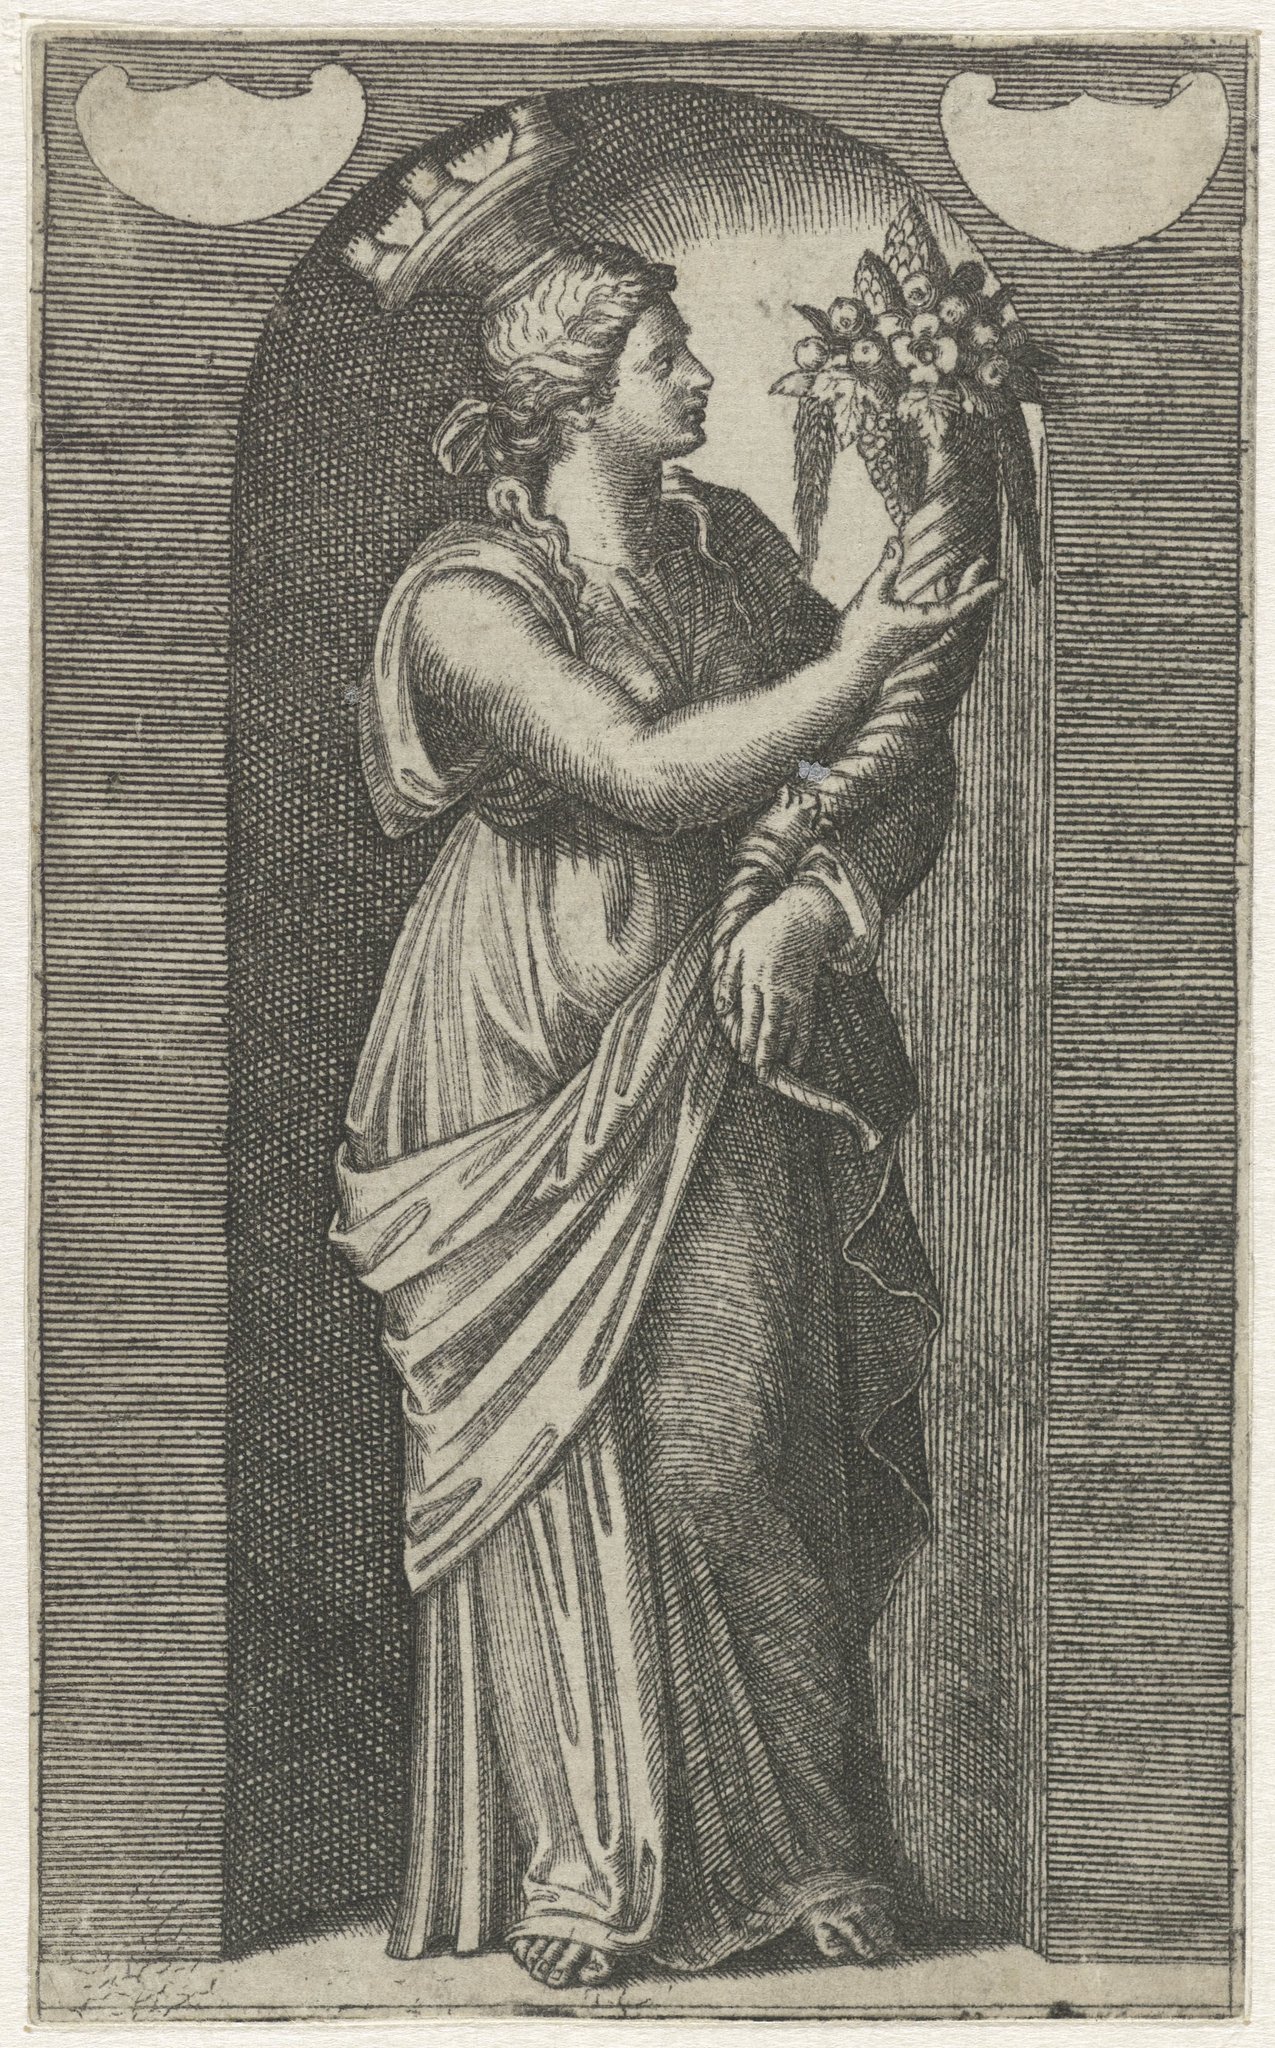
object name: print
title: Goden en muzen en jonge vrouwen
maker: marcantonio raimondi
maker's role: print maker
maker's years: 1470-1534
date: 1511-1520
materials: paper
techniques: engraving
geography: italy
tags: 'cornucopia', horn of plenty, female sex; woman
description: Prent maakt deel uit van serie van zestien prenten met Apollo, Minerva, muzen en andere vrouwen naar ontwerp van Raphael. De verschillende muzen zijn lastig van elkaar te onderscheiden.